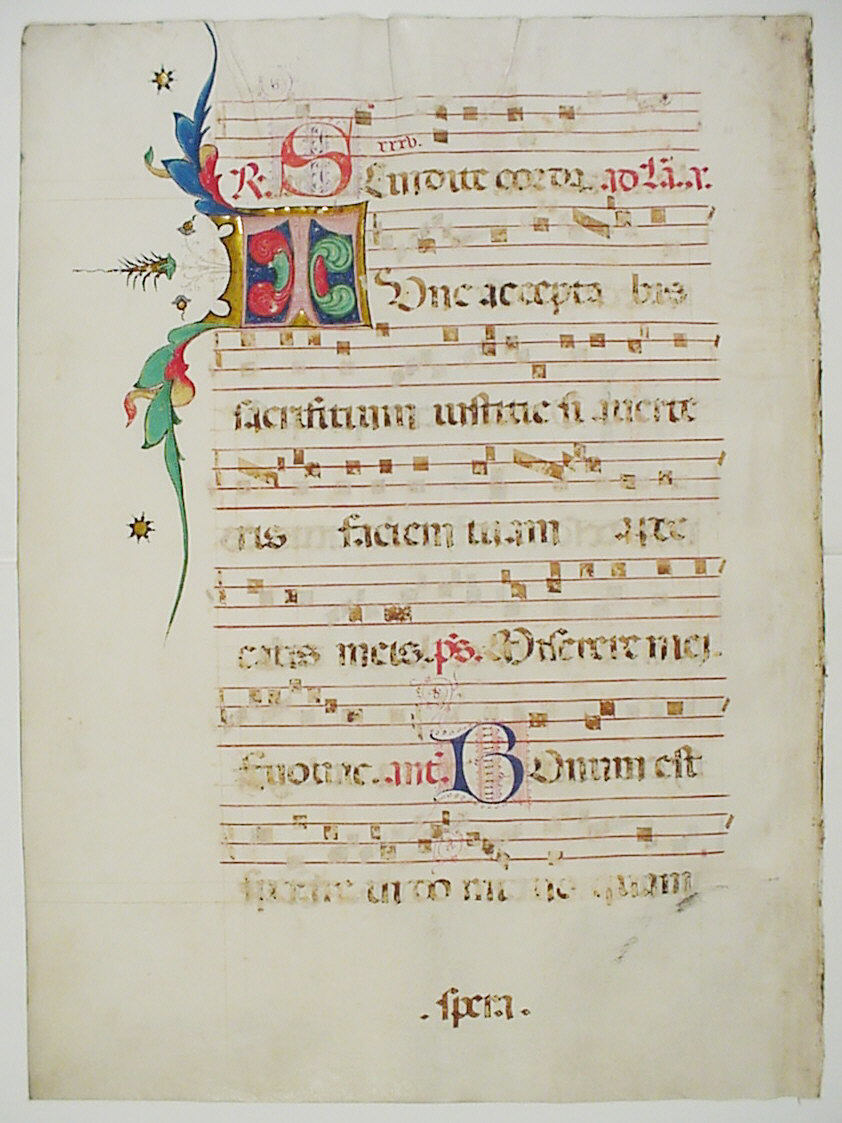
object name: antiphonary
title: Manuscript Leaf with Initial T, from an Antiphonary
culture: italian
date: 1401-1500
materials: ink, metal leaf, parchment, paint